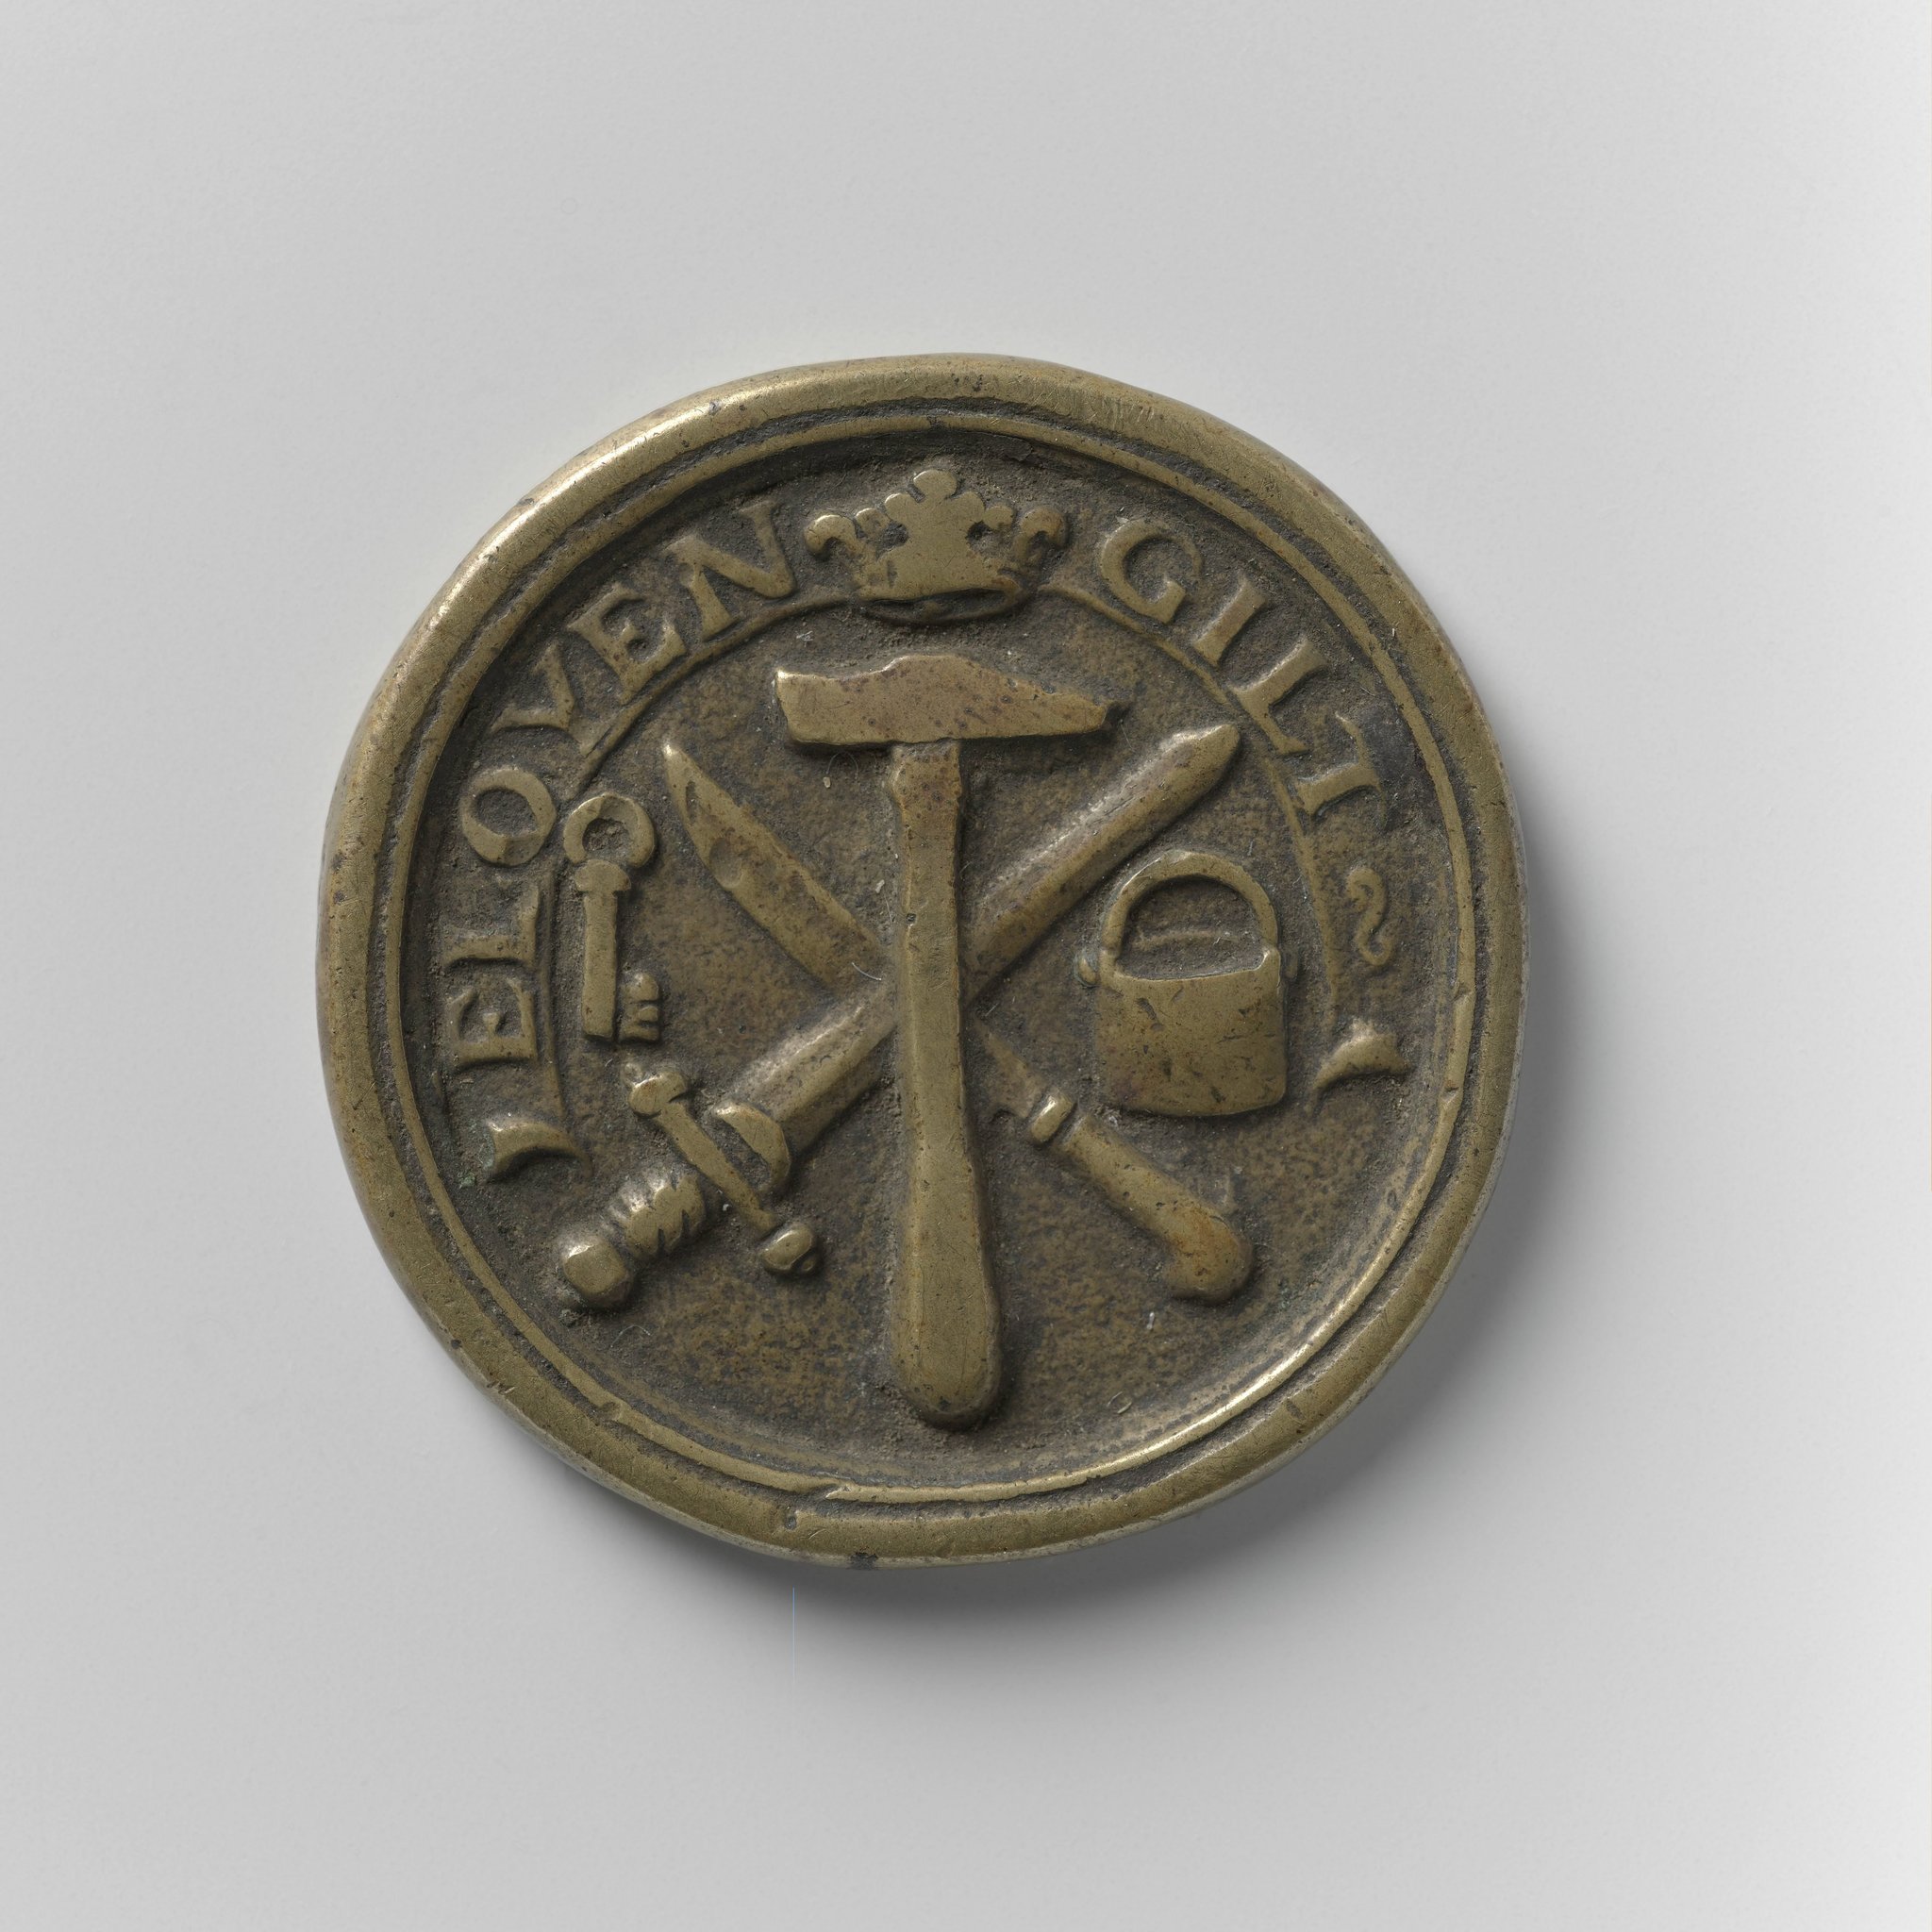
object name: medal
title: Gildepenning van het Smedengilde Sint Eloy te Amsterdam, op naam van Jacob [Pietersz ?].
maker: Anonymous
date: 1600-1800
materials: brass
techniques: casting, engraving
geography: amsterdam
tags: amsterdam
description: Messing penning van het Smidsgilde. Voorzijde: gekroond wapenschild, geflankeerd door twee leeuwen boven cartouche met opschrift. Keerzijde: kruis bestaande uit gekroonde hamer, zwaard en mes; links: sleutel, rechts: emmer